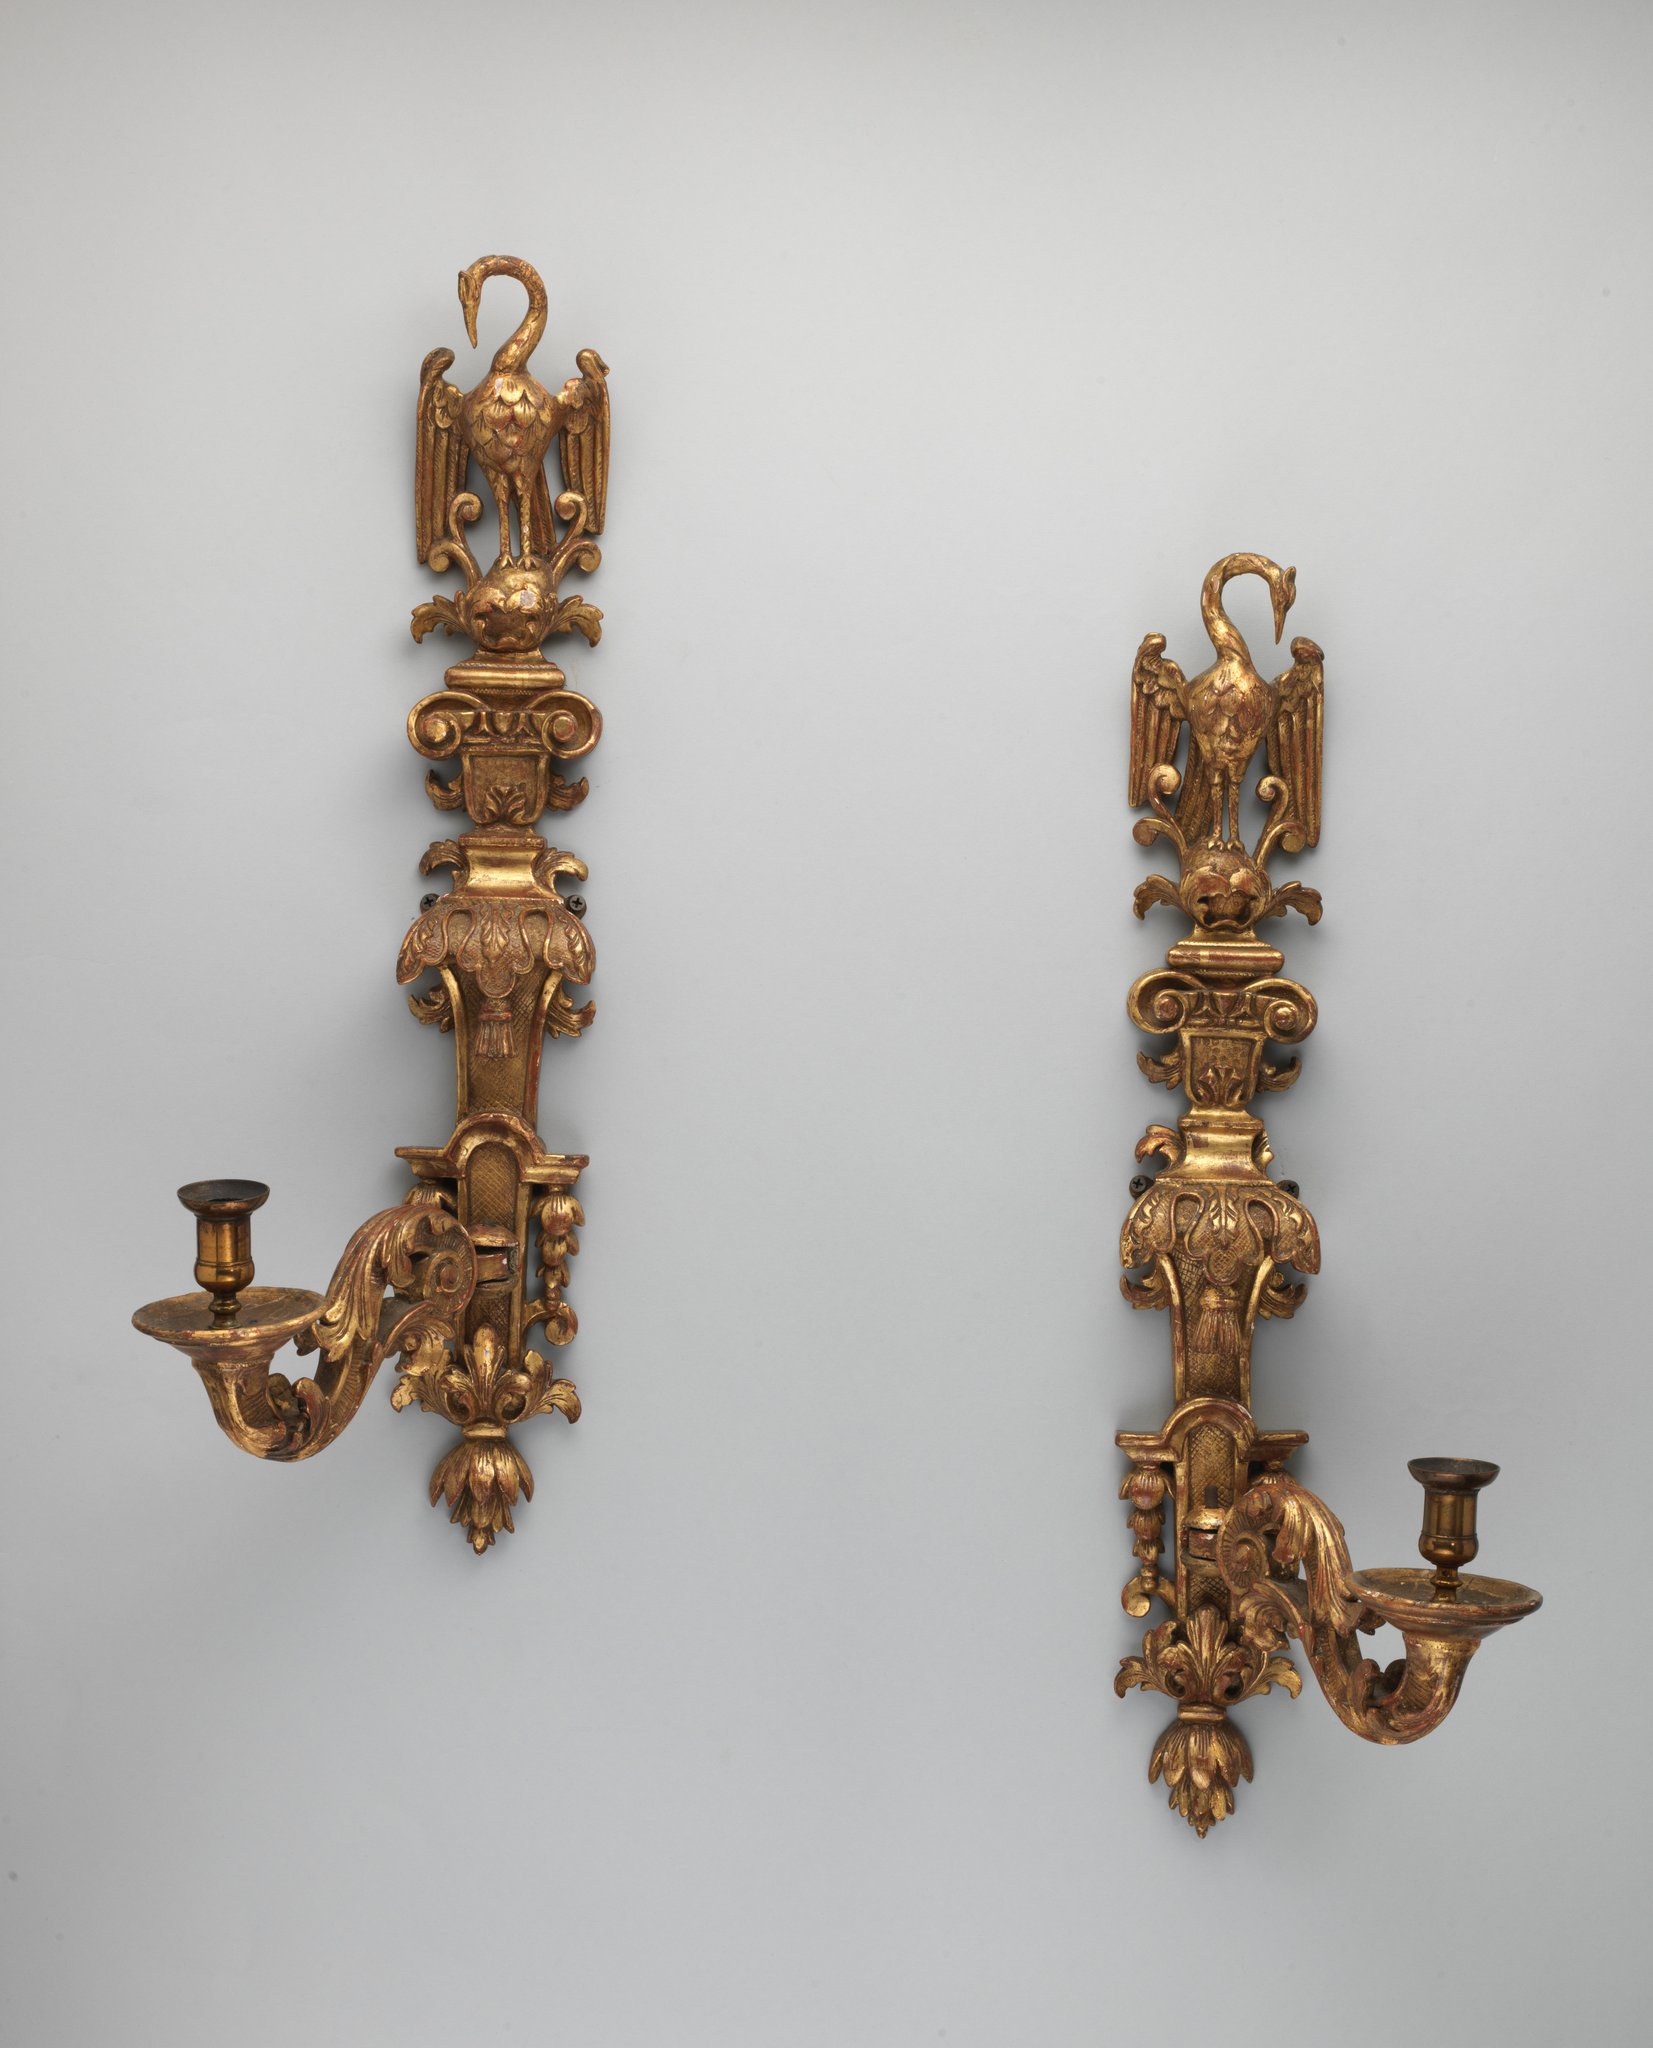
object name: sconce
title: Pair of single-light sconces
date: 1690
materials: wood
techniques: carving, gilding